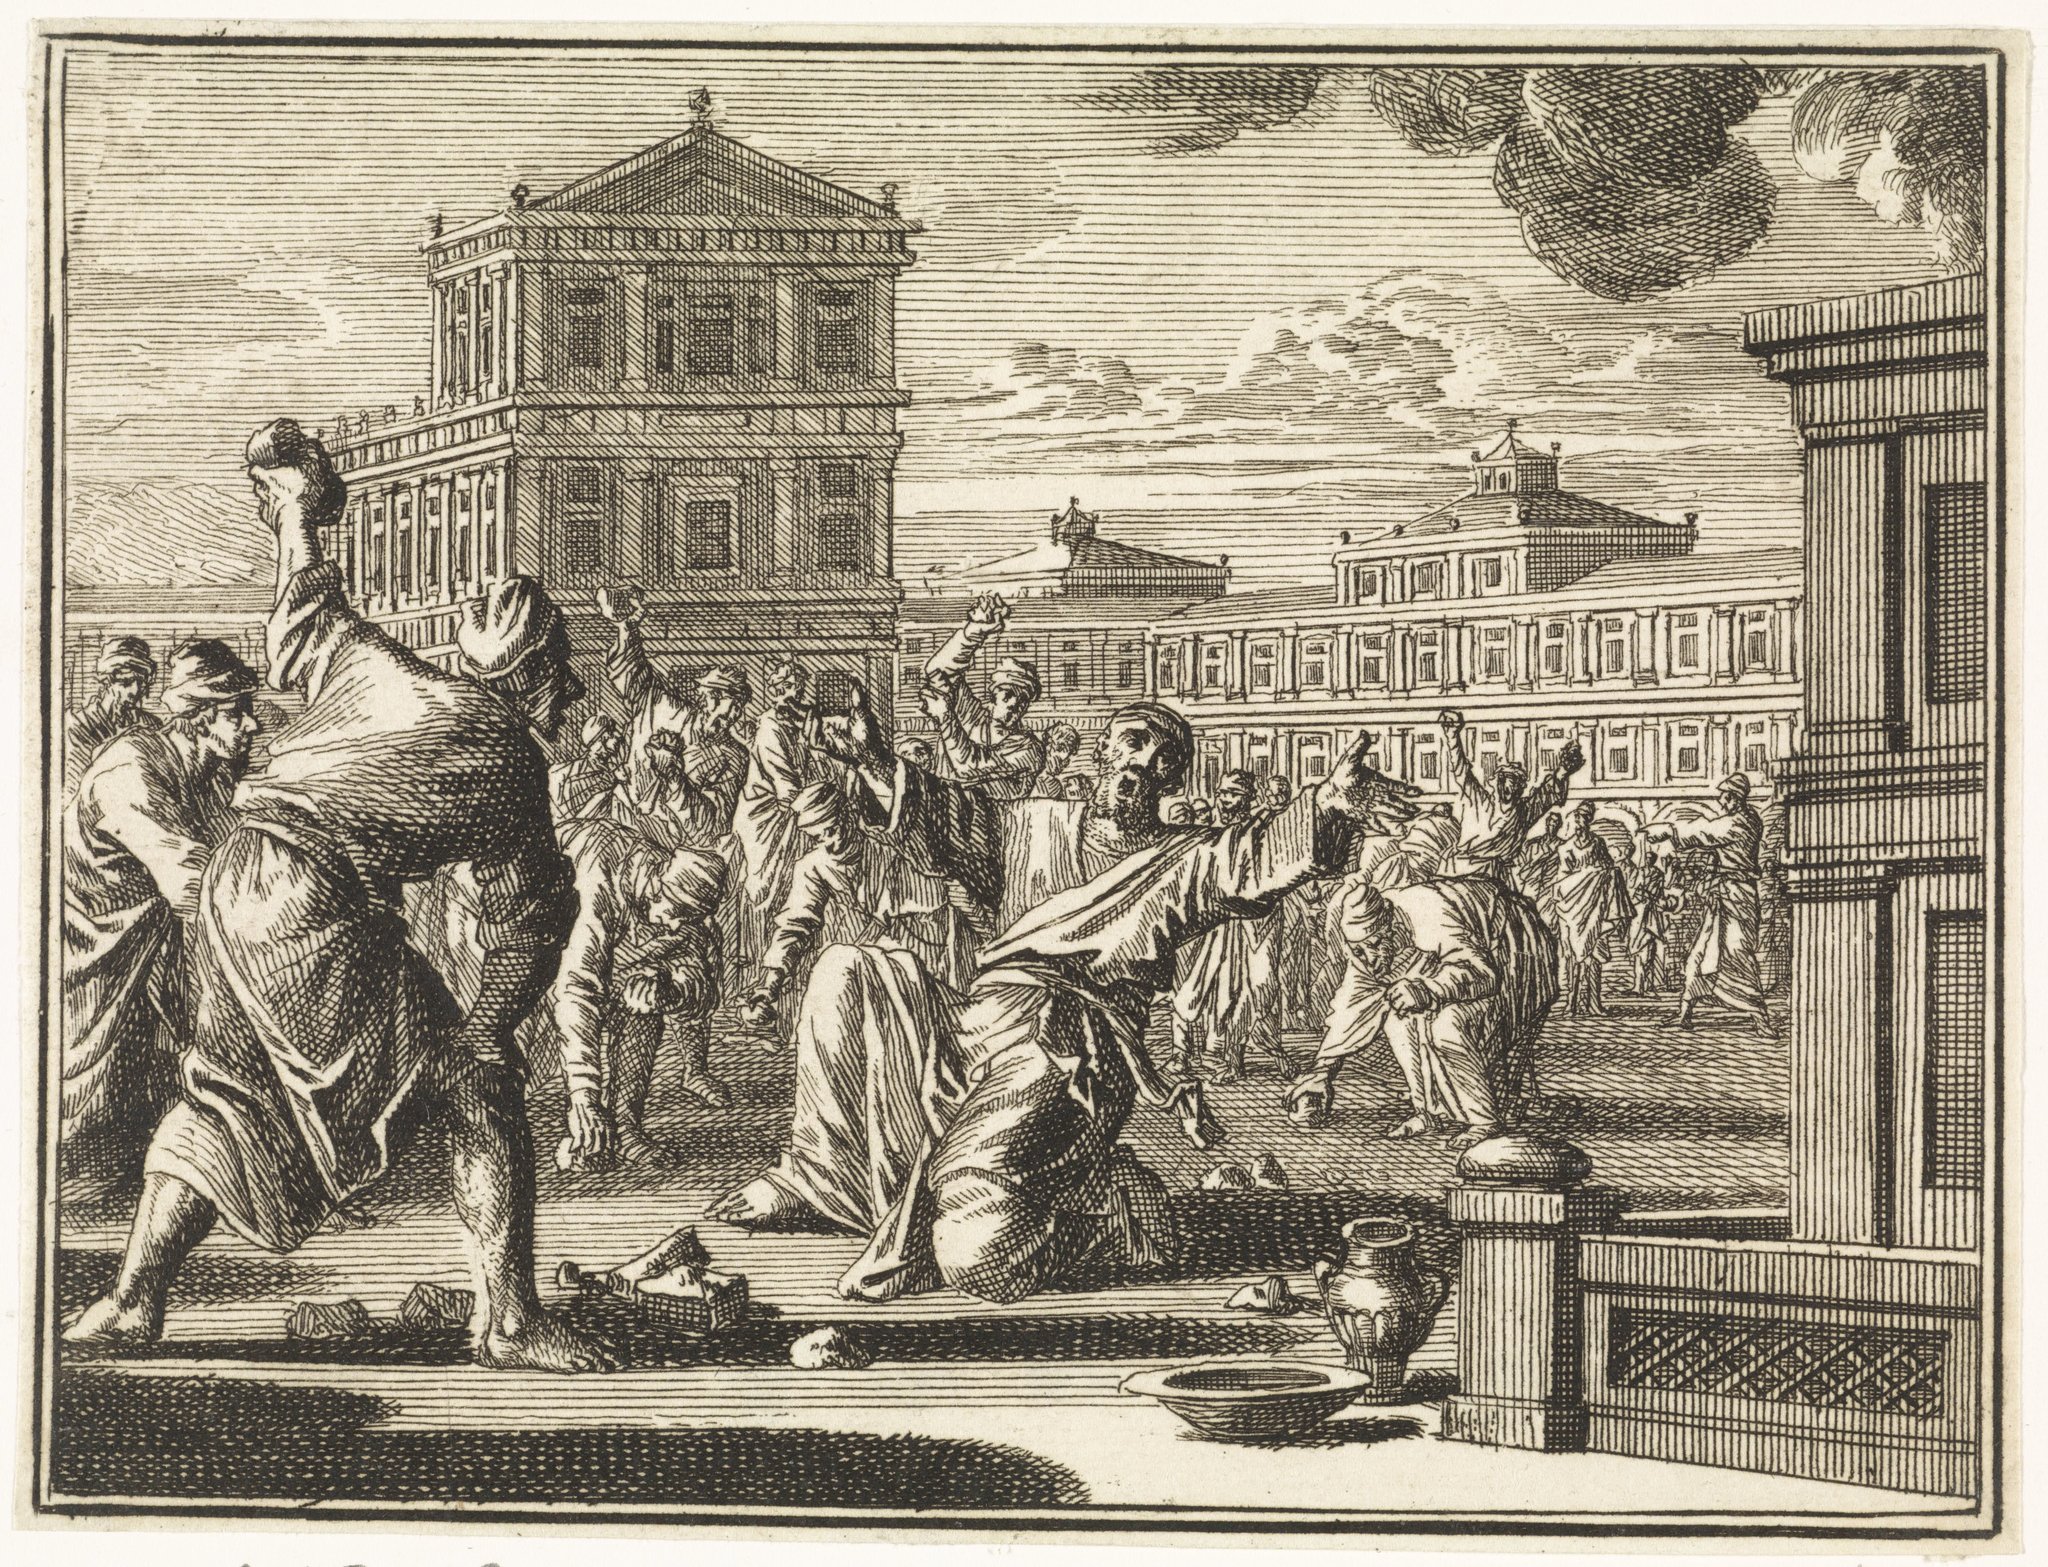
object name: print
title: Zacharia wordt gestenigd in opdracht van de koning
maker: jan luyken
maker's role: draughtsman, print maker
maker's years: 1649-1712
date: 1712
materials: paper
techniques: etching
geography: amsterdam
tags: at the king's order the people stone zechariah in the temple courtyard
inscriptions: collector's mark: Lugt 2228, number: ‘151’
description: Illustratie uit: Luyken, Jan. De schriftuurlyke geschiedenissen en gelykenissen van het Oude en Nieuwe Verbond, 2 delen. Amsterdam: Wed. Pieter Arentsz II en Cornelis van der Sys, 1712, dl. I.